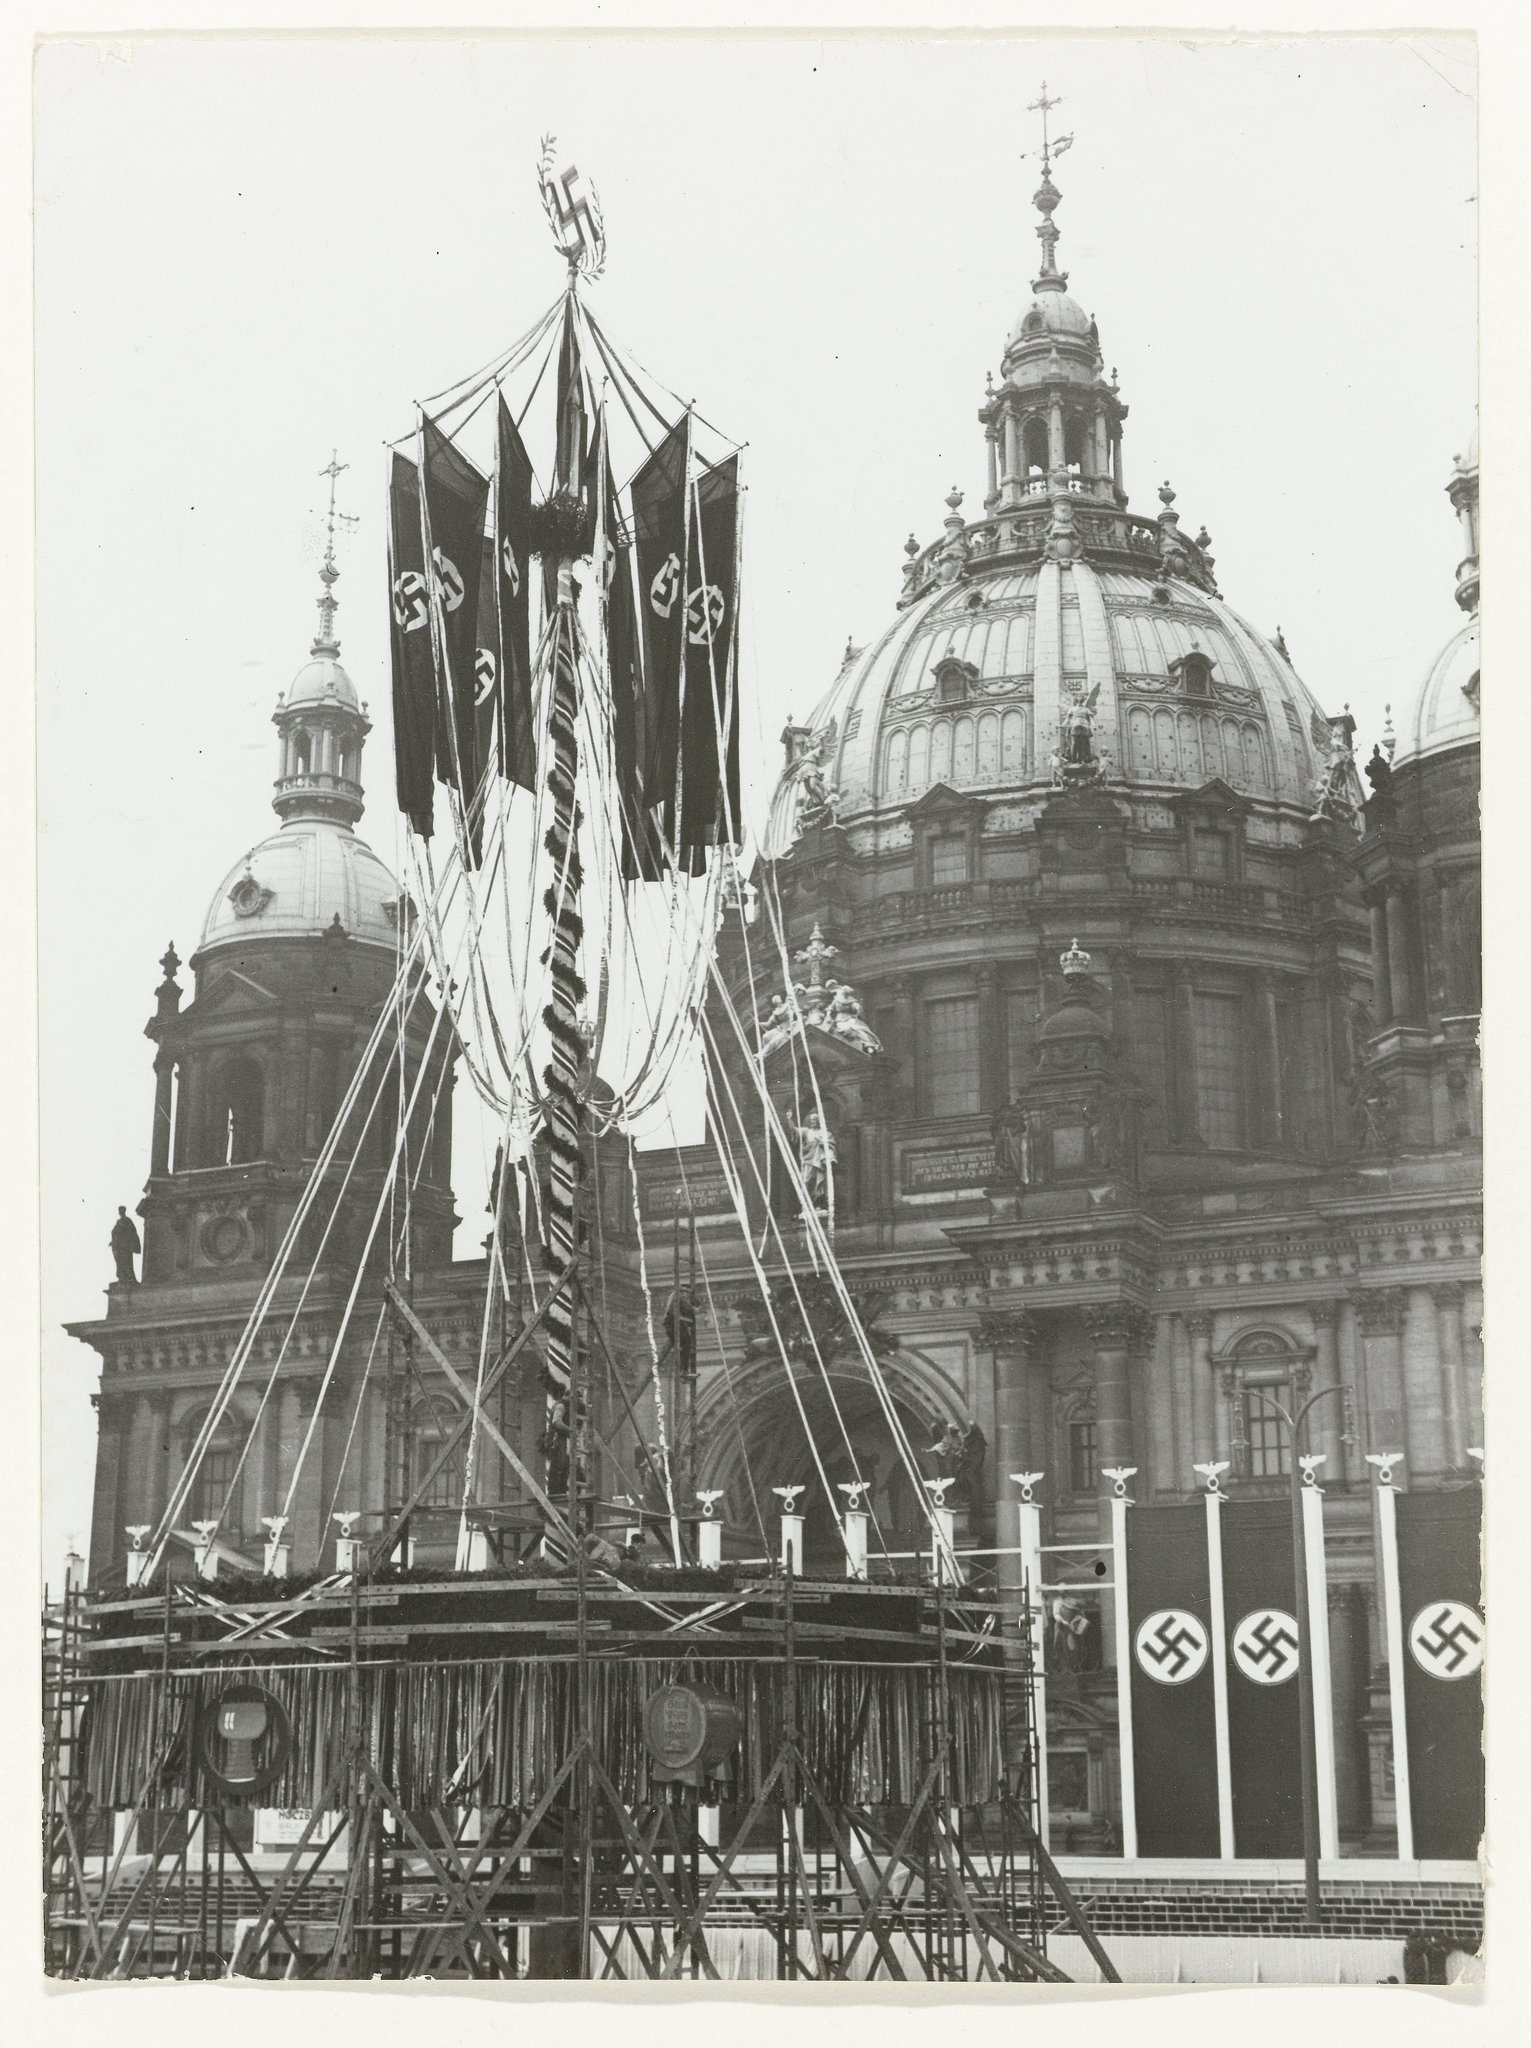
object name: photograph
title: Manifestatie in Hitler Duitsland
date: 1936-1940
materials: photographic support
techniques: photography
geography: berlin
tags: berlin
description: De Domkerk ( 1905 ) in Berlijn ( Berliner Dom) tijdens een manifestatie na de machtsovername door Hitler.Voor de kerk staat een podium, daar op een standaard met vlaggen met hakenkruizen.